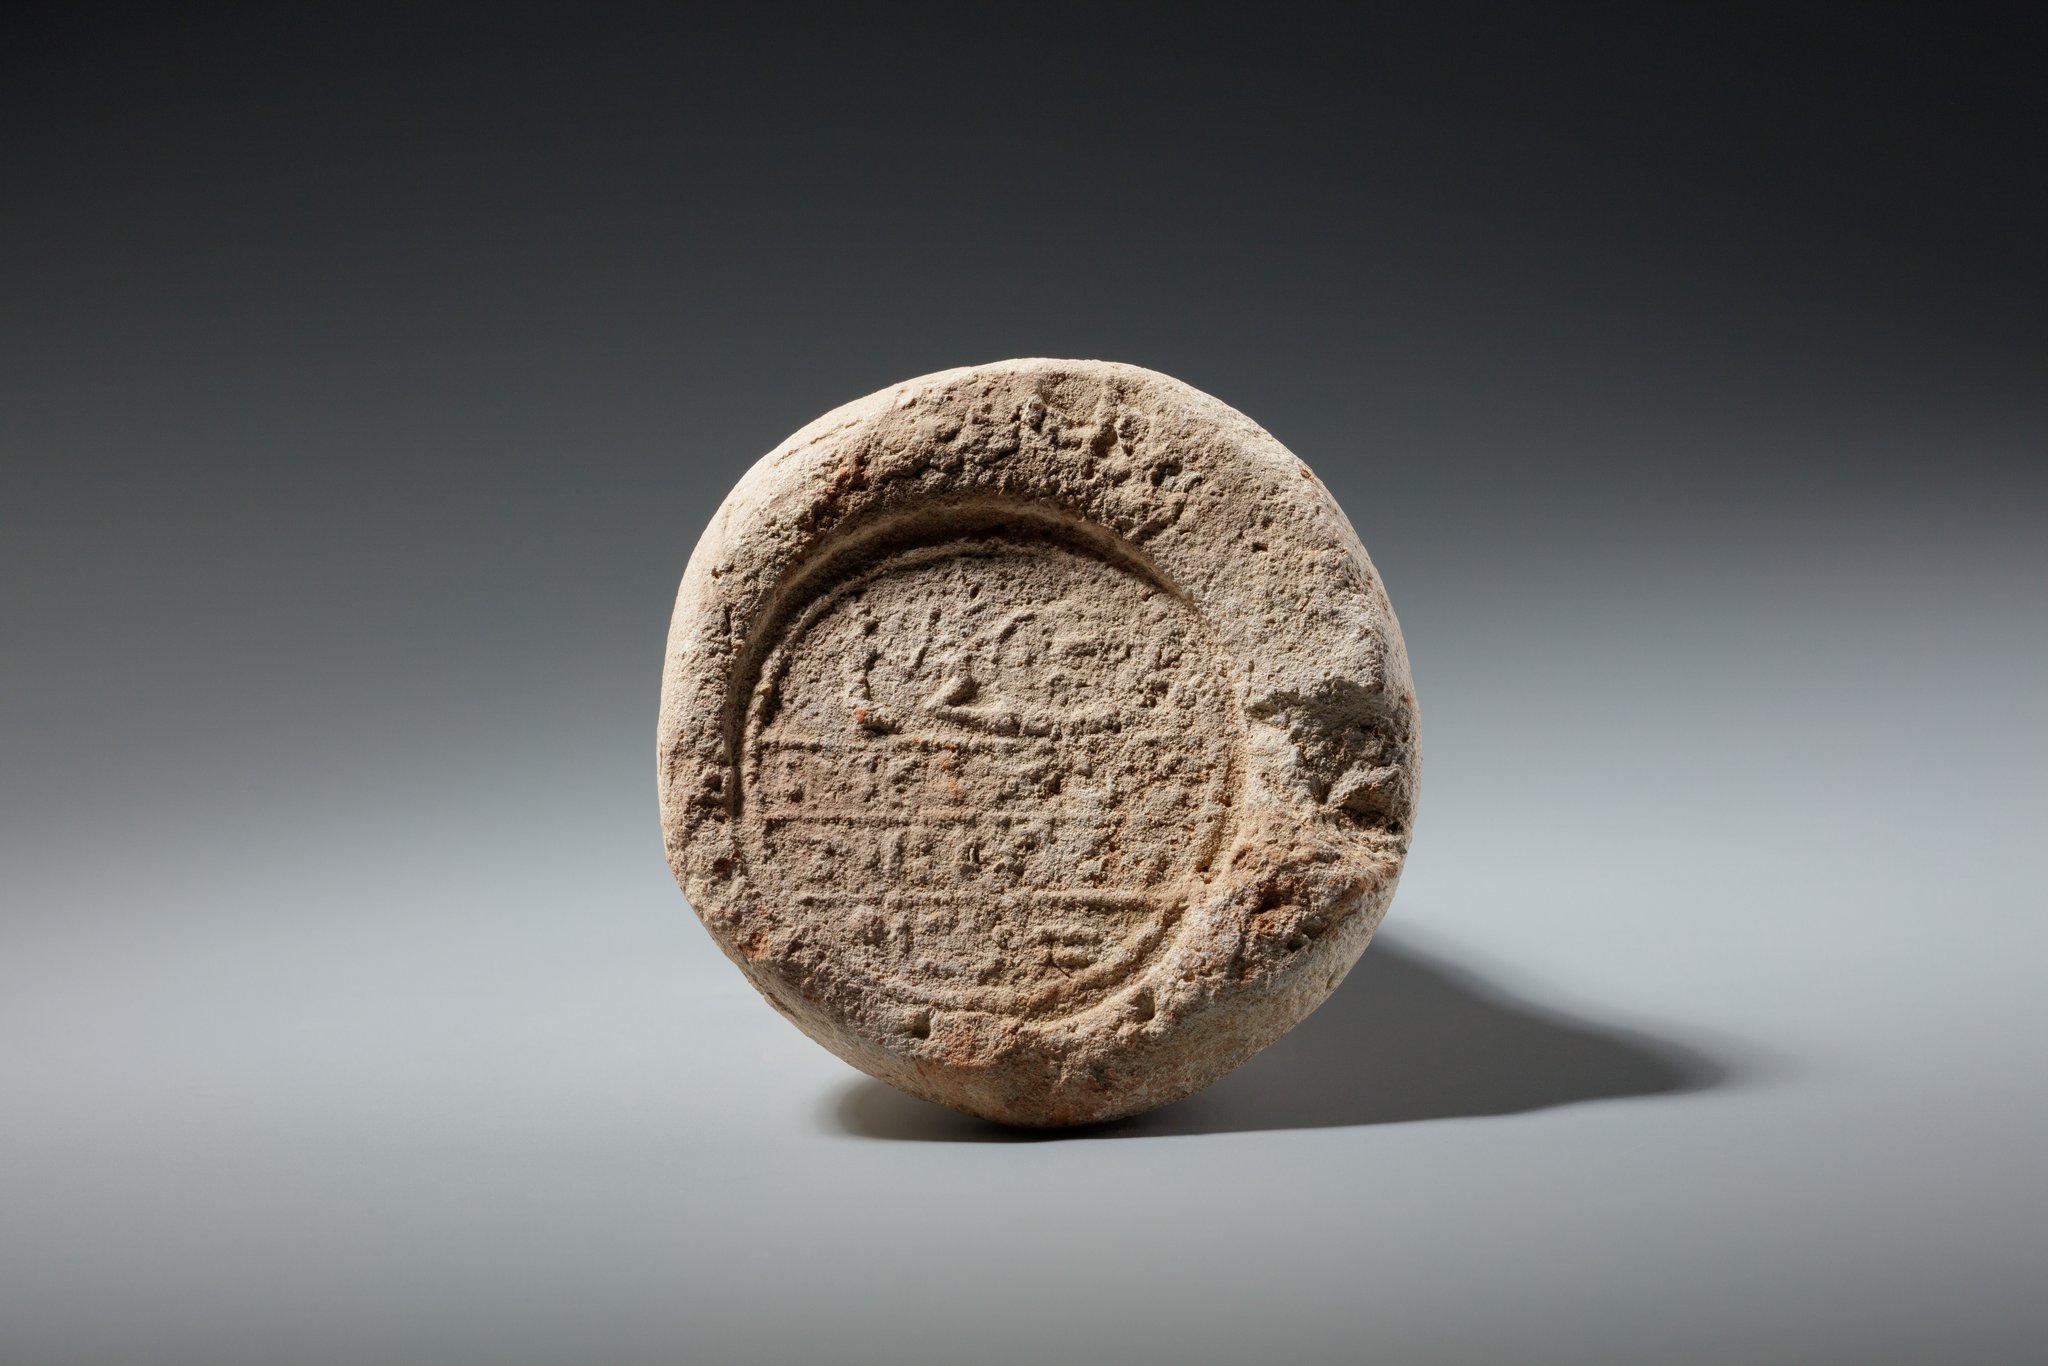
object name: cone, davy 585, khaempashemes, butler, divine adoratrice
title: Funerary Cone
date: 1550-1295 BCE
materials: pottery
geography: egypt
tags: hieroglyphs